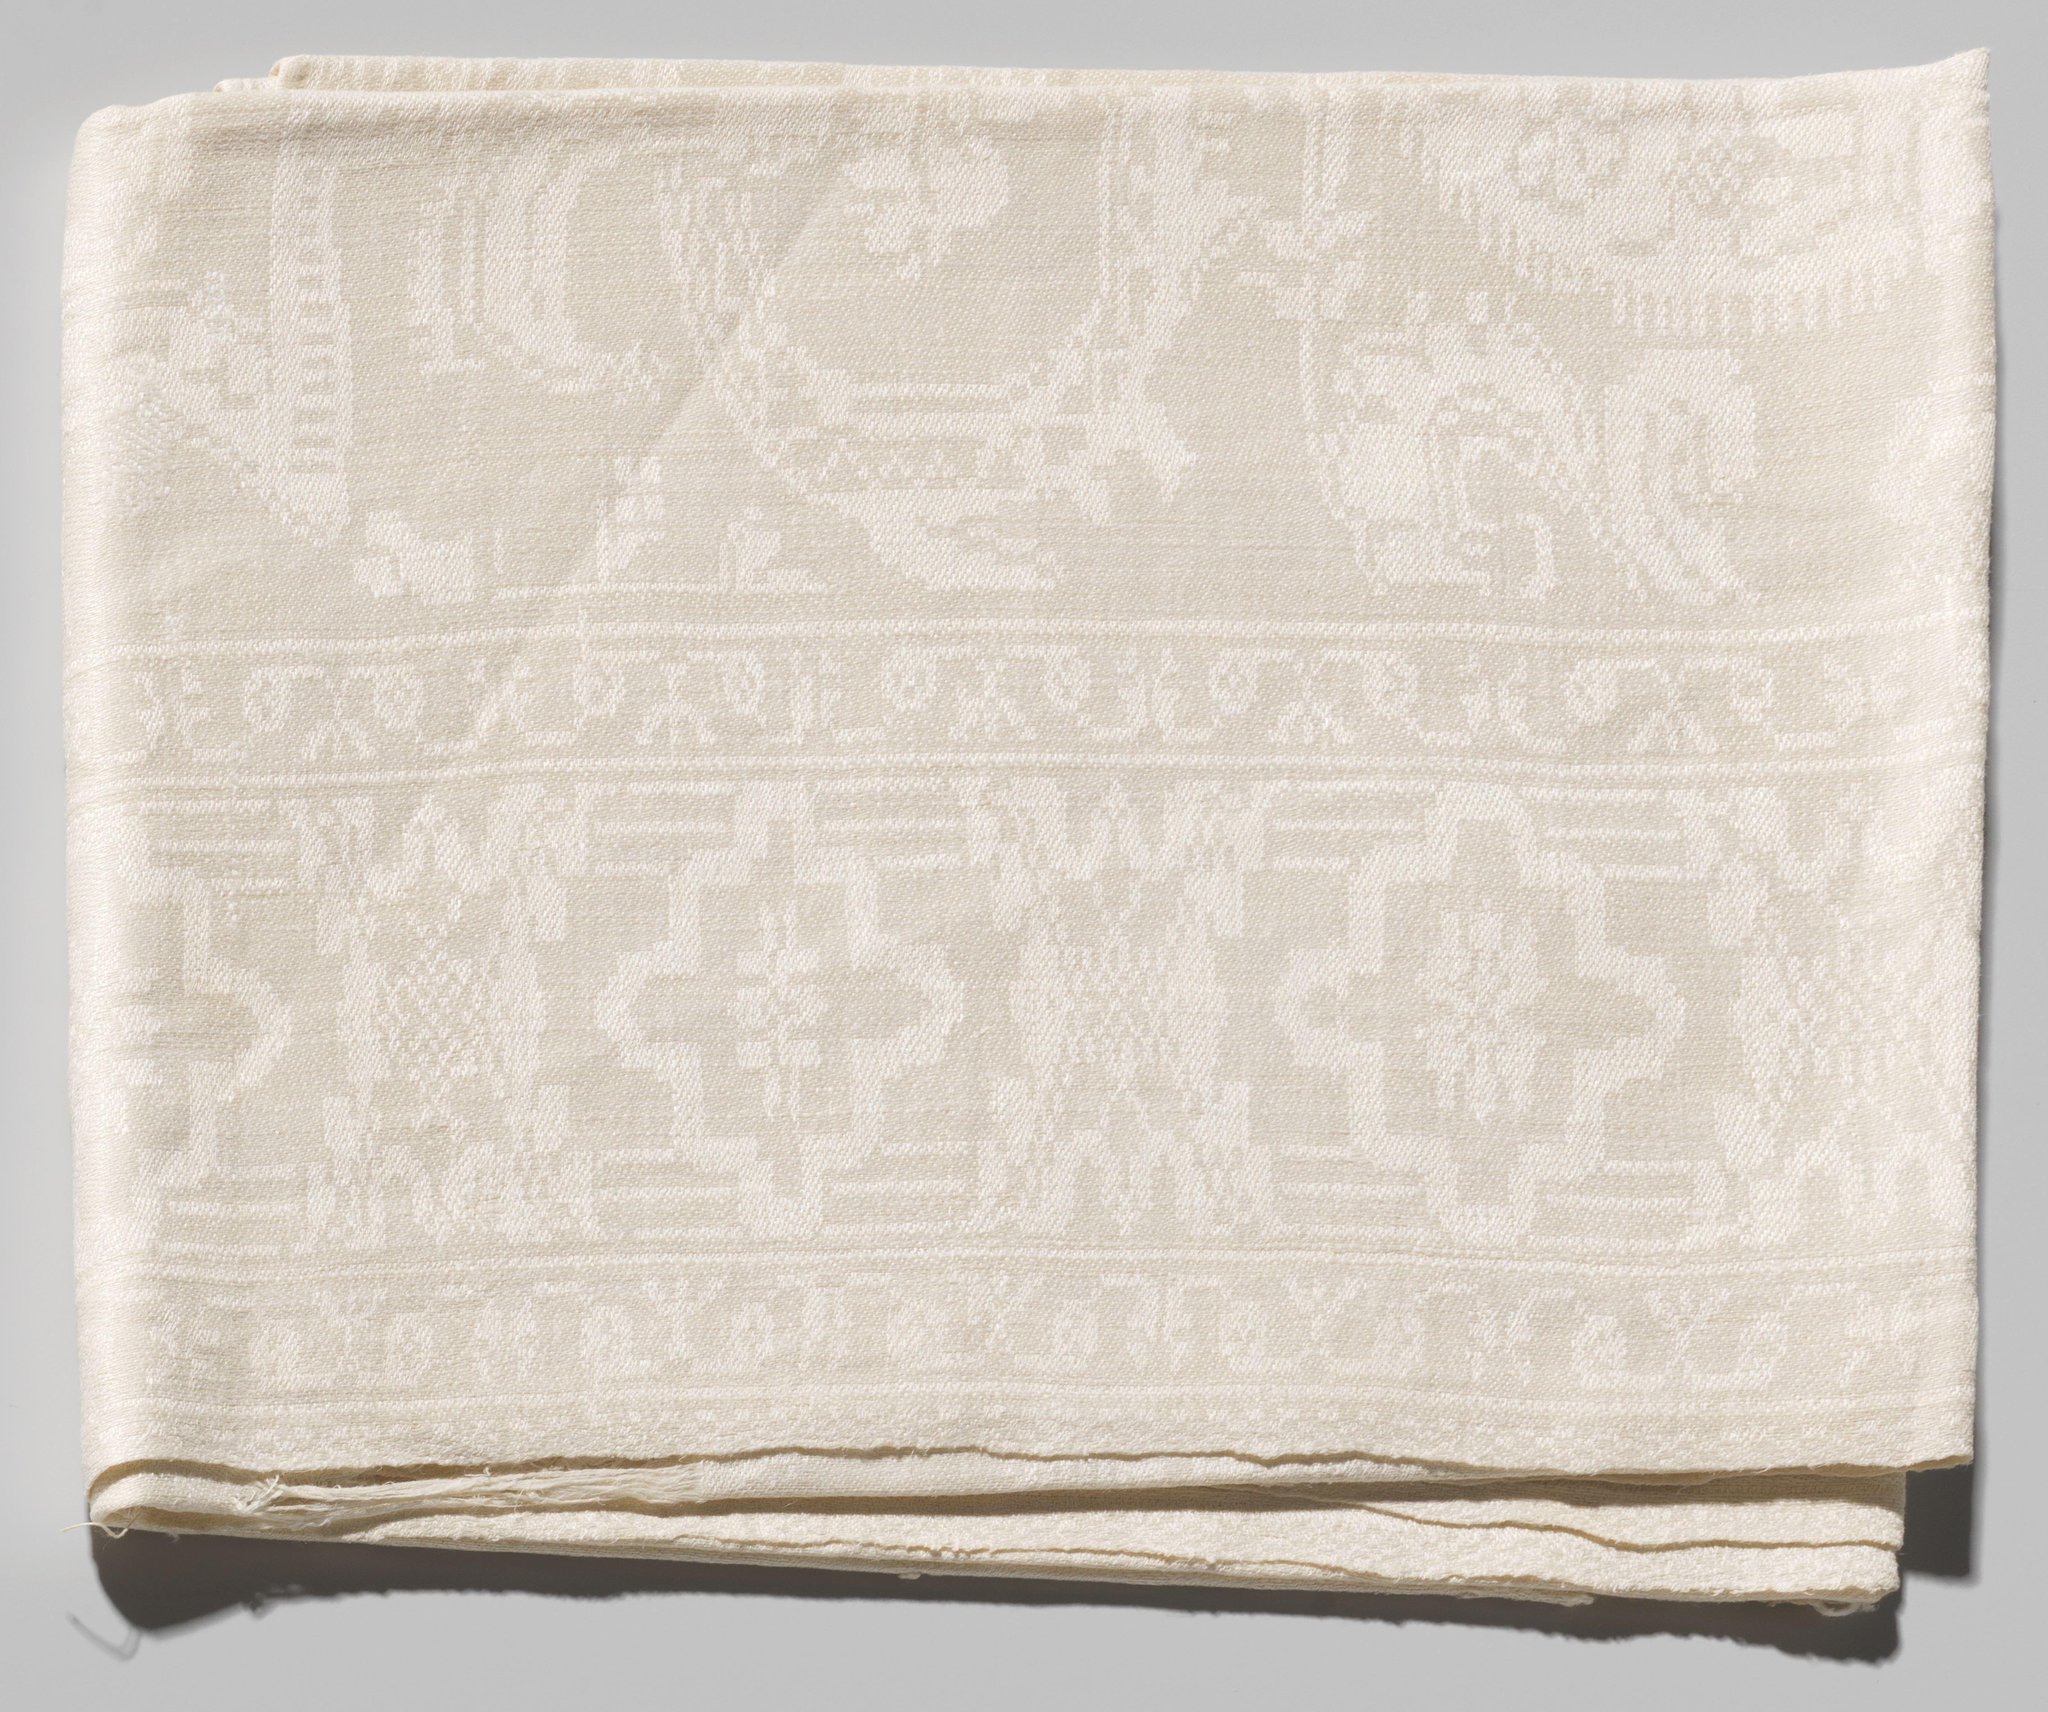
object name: napkin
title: Servet met agrementvoluten doorsneden door acanthusvoluten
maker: Anonymous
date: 1675-1700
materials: linen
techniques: damask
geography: low countries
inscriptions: mark: ‘18’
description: Servet van linnendamast met groot patroon van agrementvoluten, doorsneden door acanthusvoluten. Voerlijnen van symmetrisch gestelde agrementen met bloemvulling vormen elkaar rakende spiralen, holle spitsboog, kwartcirkels en tegengestelde spiralen. Acanthusranken met rasterwerk en vertakkingen vormen C-voluten. Liggende randen: getrapgevulde zigzagbanden waartussen driekhoek en driebloemige tak. Staande randen: afwisselende ruit- en kruisvormige cartouches. Hoeken: tor. Binnen- en buitenzomen met reciproque granaatappelrank. Rondom: blokkenrand.